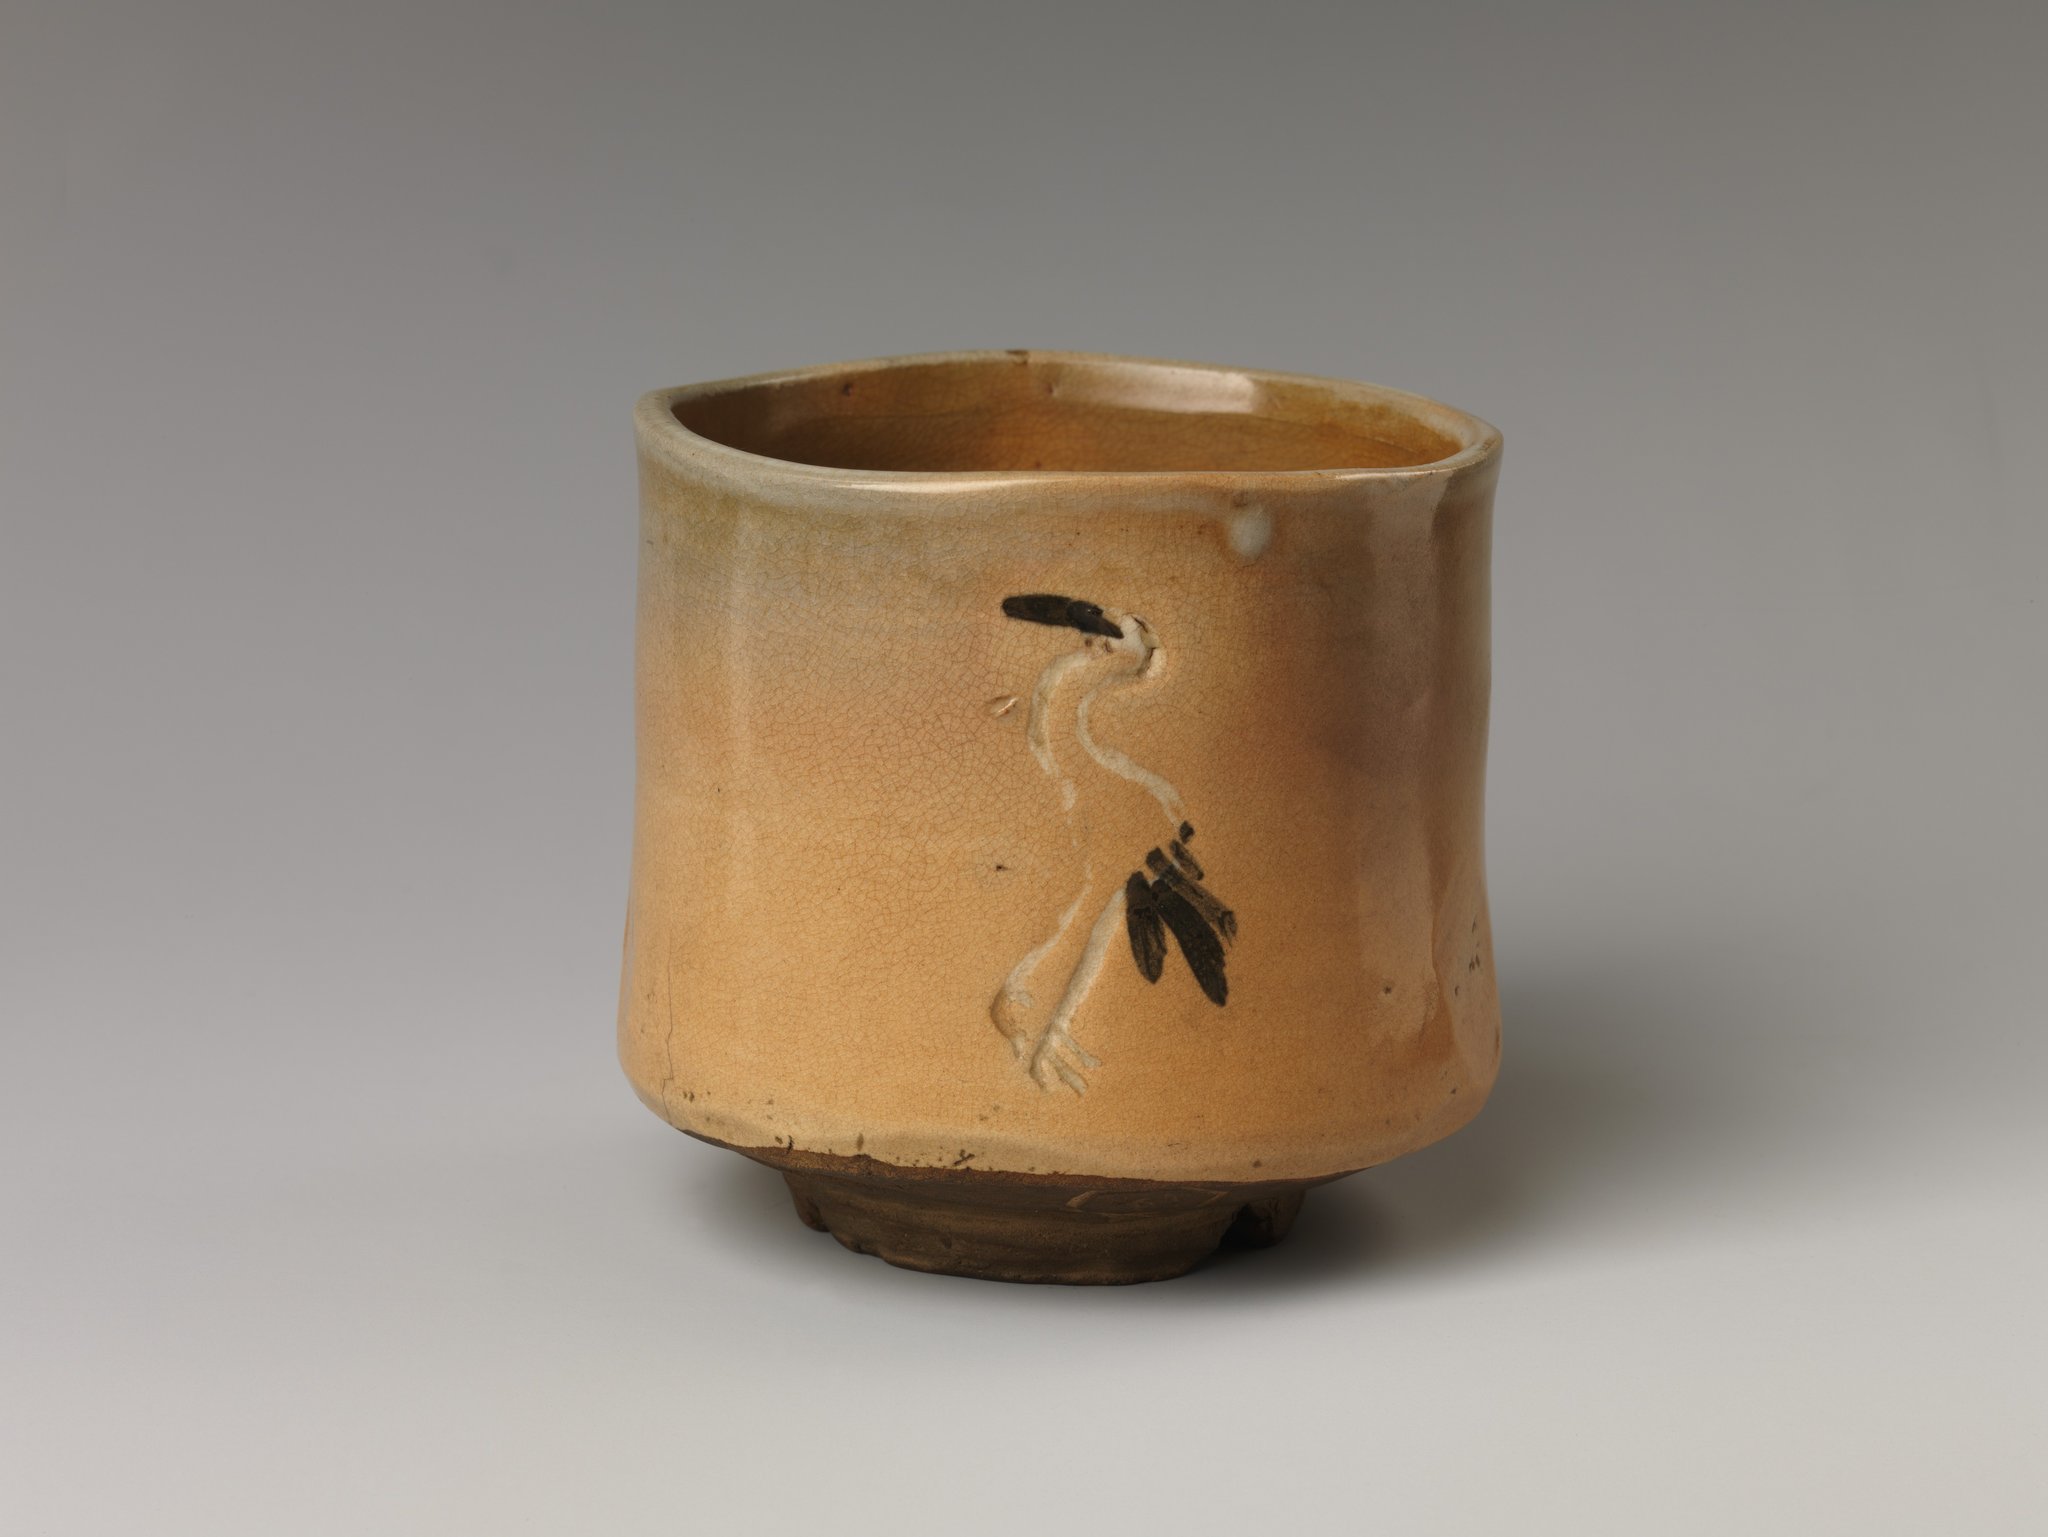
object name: teabowl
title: Gohon (Korean-Style) Tea Bowl with Cranes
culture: japanese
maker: kiyomizu rokubei i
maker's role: artist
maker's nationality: japanese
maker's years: 1737-1799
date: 1751-1800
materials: glaze, iron, stoneware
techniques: inlay, underglaze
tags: cranes